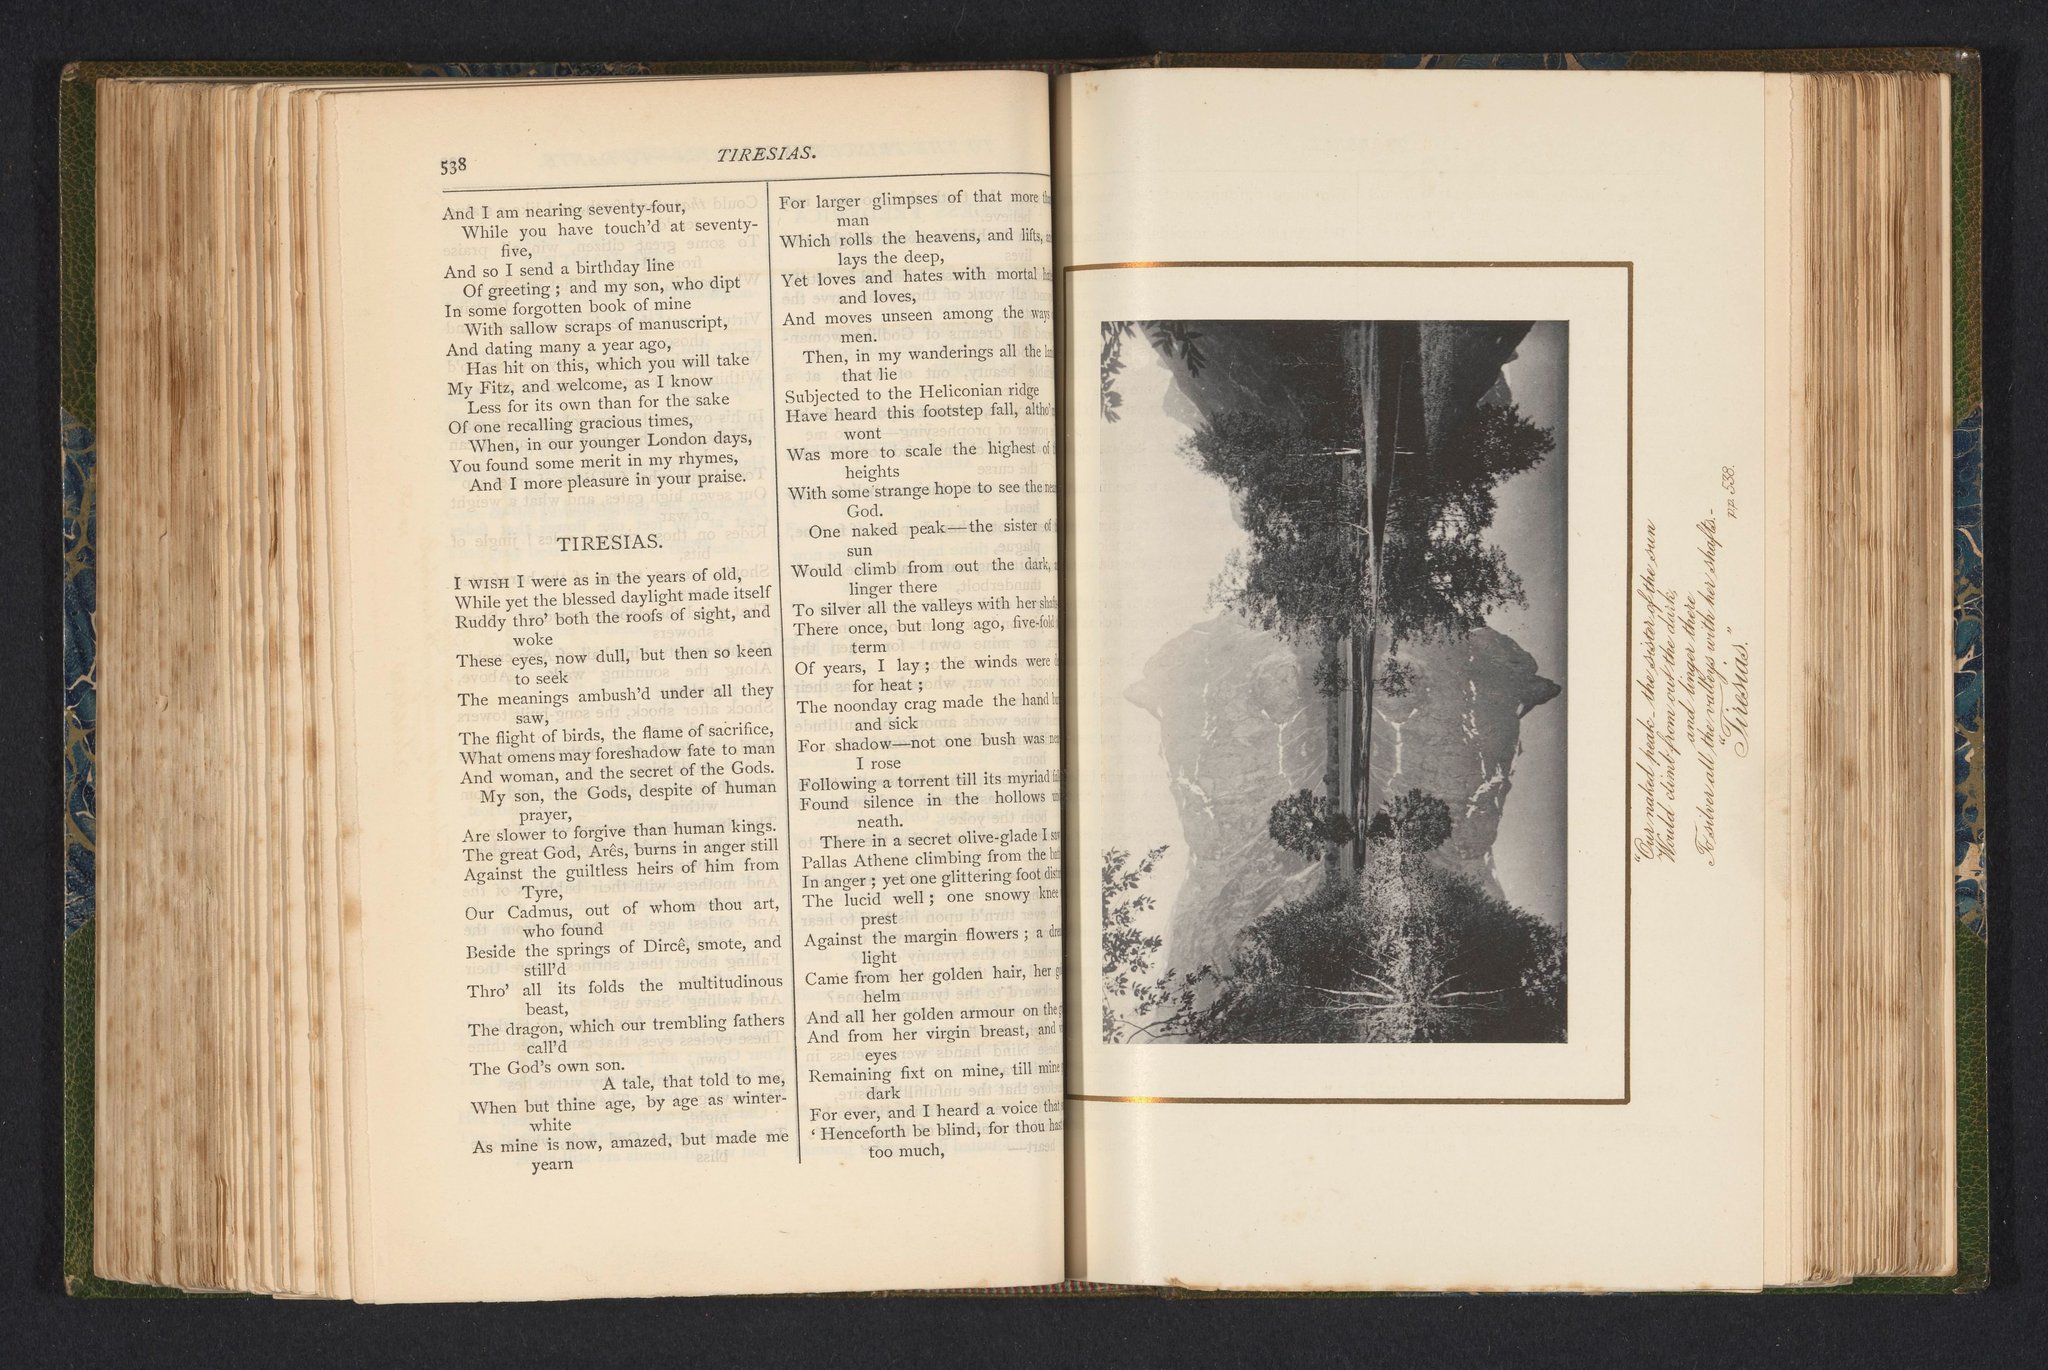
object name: photograph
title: Gezicht op een poel, met op de achtergrond een berg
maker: Anonymous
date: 1885-1895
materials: photographic support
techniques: platinum process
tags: pond, pool, mountains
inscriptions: inscription: ‘"Our naked peak (...) Tiresias."’